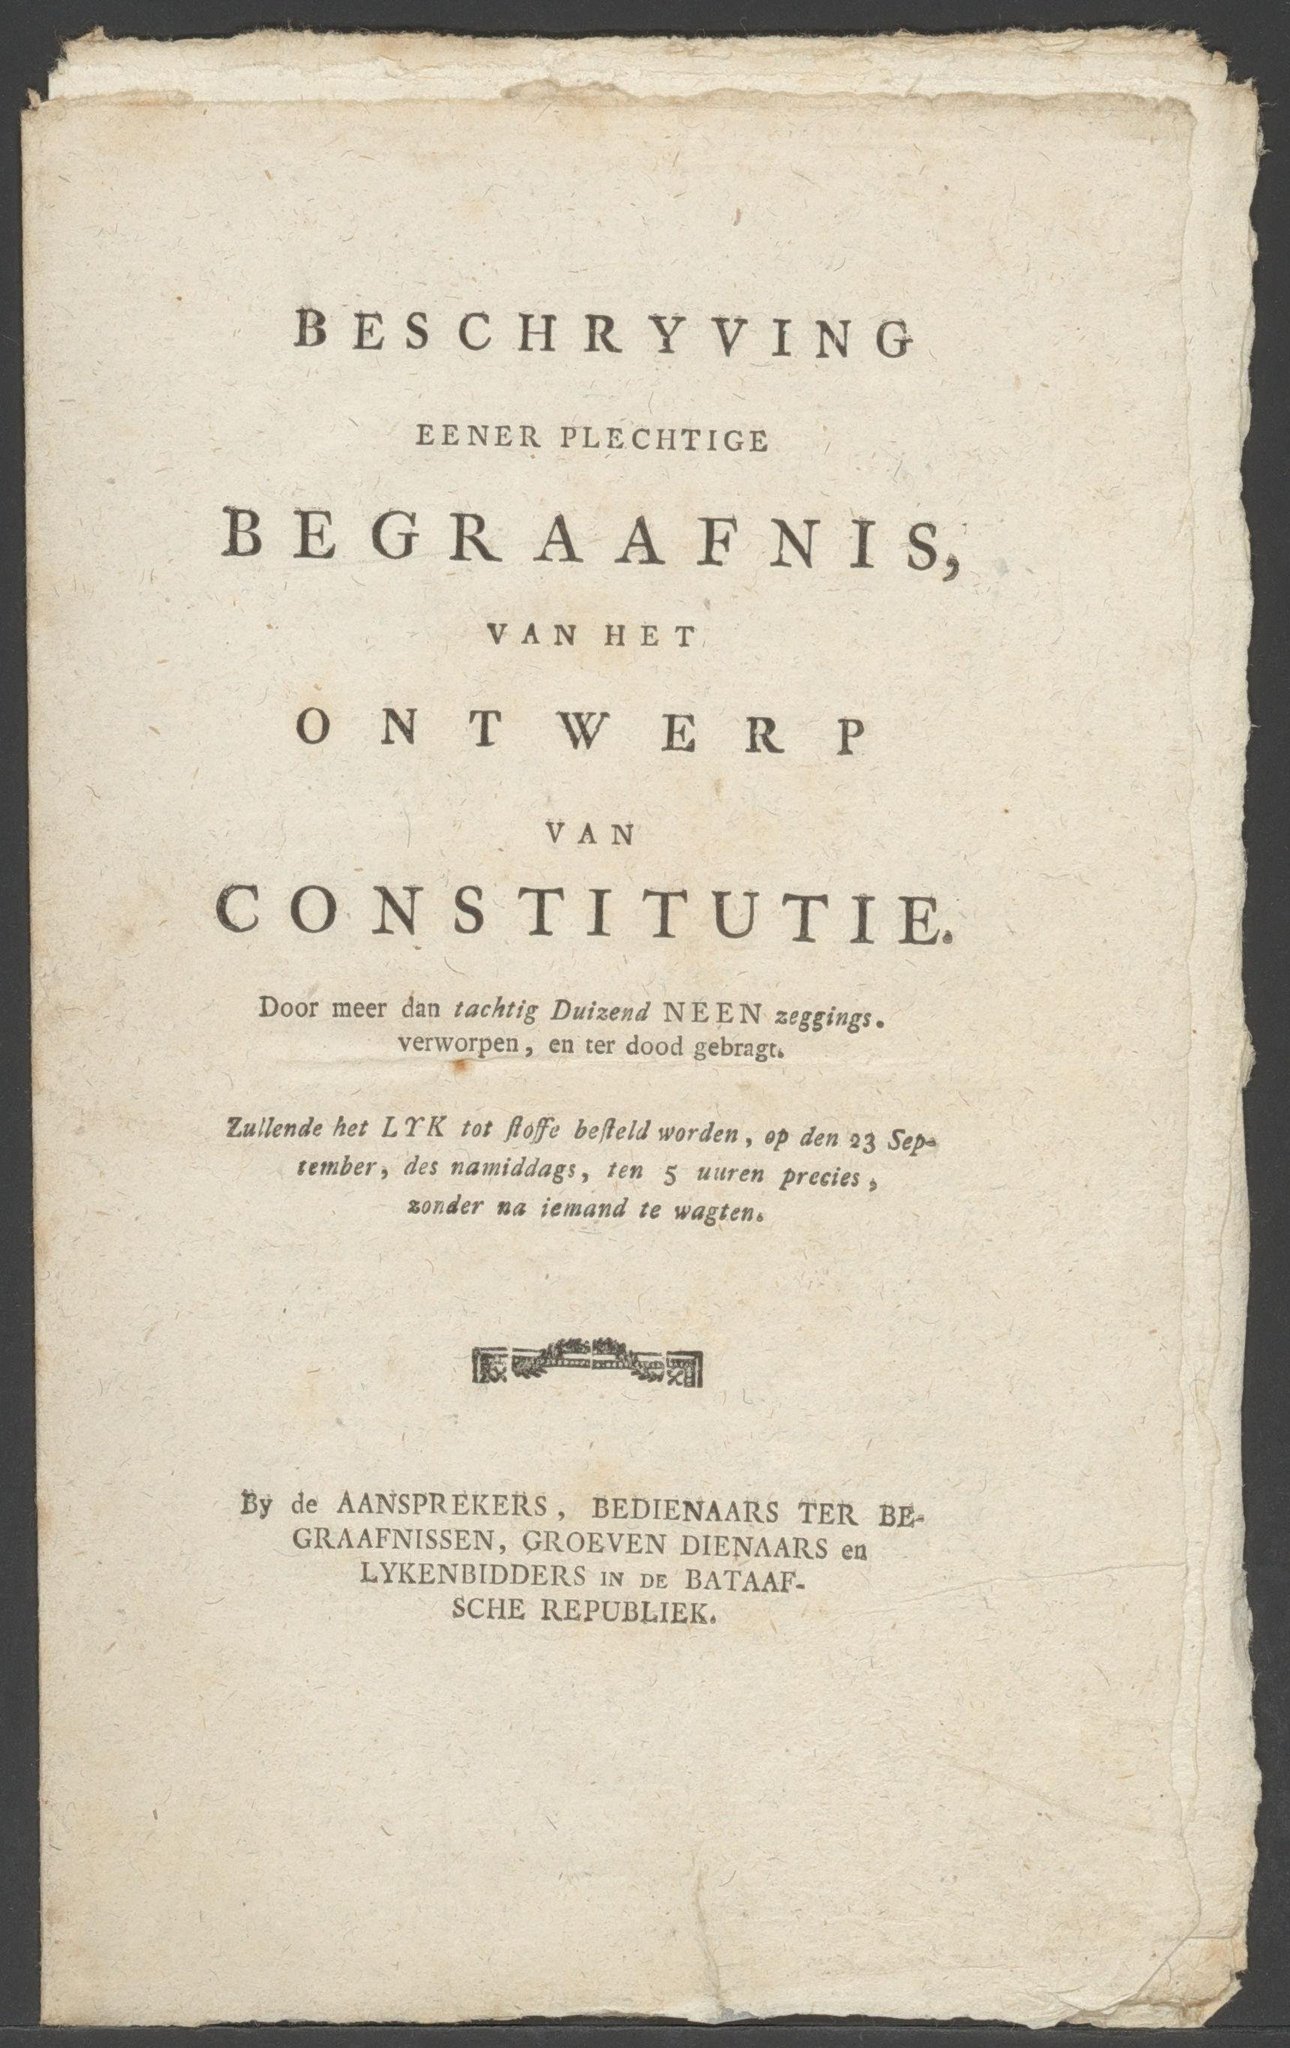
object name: pamphlet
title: Pamflet over de begrafenis van de Constitutie, 1797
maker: Anonymous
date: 1797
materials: paper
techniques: letterpress printing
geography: netherlands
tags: mourning card, death notice, obituary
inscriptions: collector's mark, collector's mark: Lugt 1641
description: Satirisch pamflet over de begrafenis van de Constitutie op zaterdag 23 september 1797 te Den Haag. Bestaande uit zestien genummerde bladzijden. Onderwerpsrubrieken binnen de Atlas Zeden en Gewoonten: Des Menschen Begin, Midden en Einde. Begrafenissen, lijkzangen, grafschriften, pamfletten.